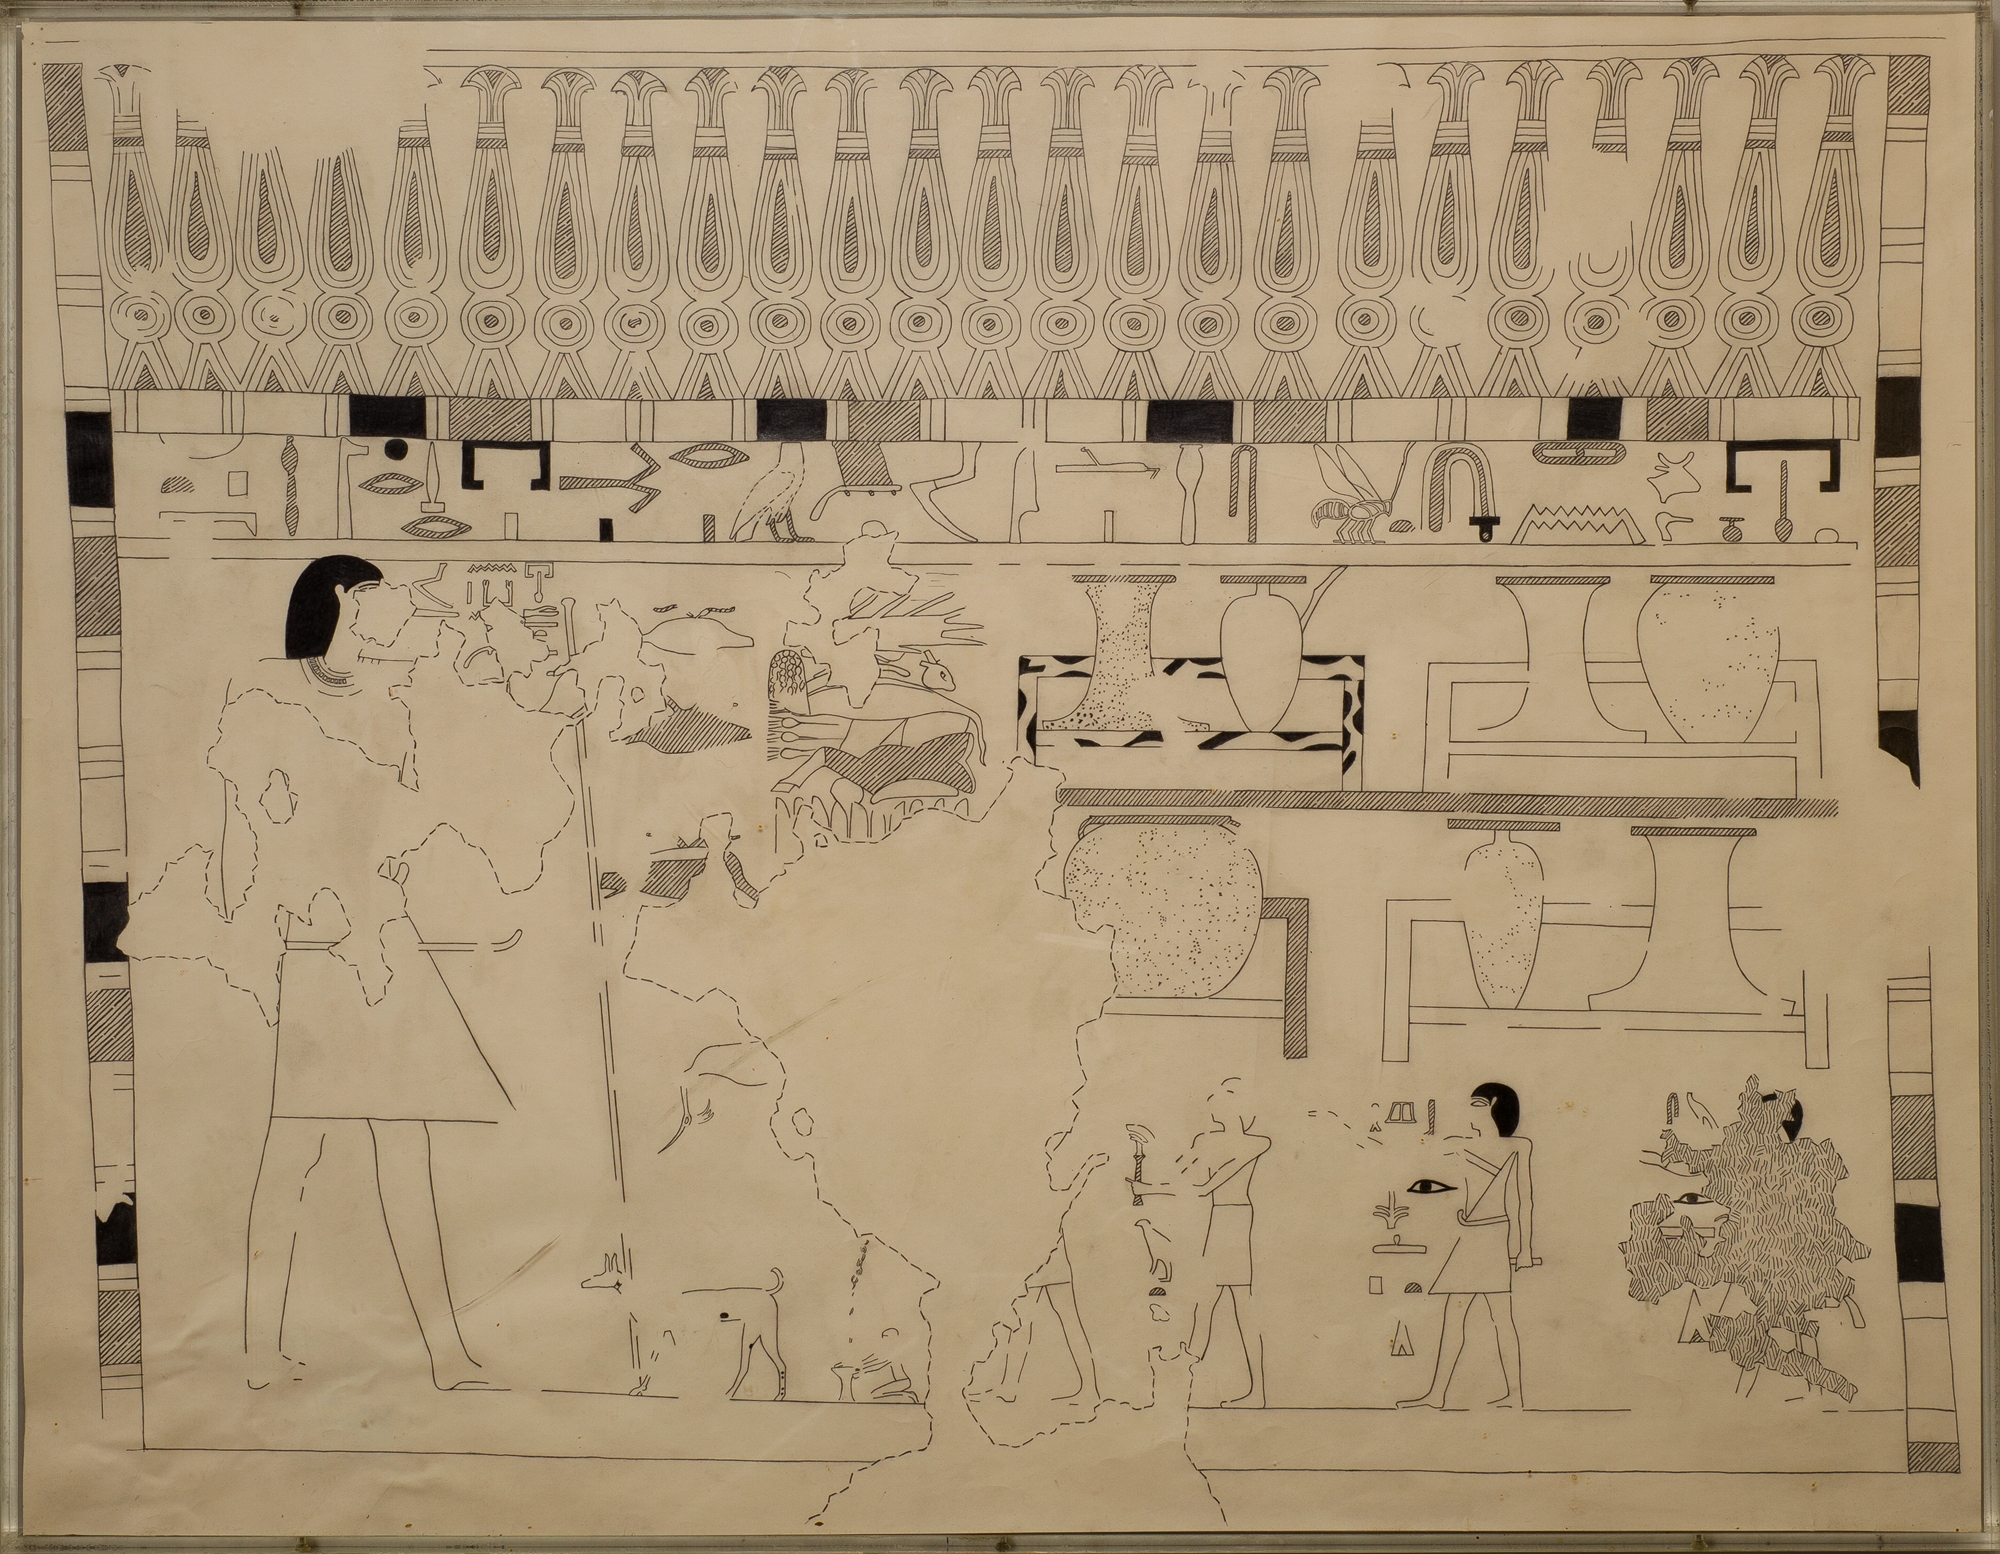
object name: facsimile, djari tt 366, offering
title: Offering Scene, Tomb of Djari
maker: unknown copyist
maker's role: artist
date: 2050-2000 BCE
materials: ink, paper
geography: egypt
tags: human figures,hieroglyphs